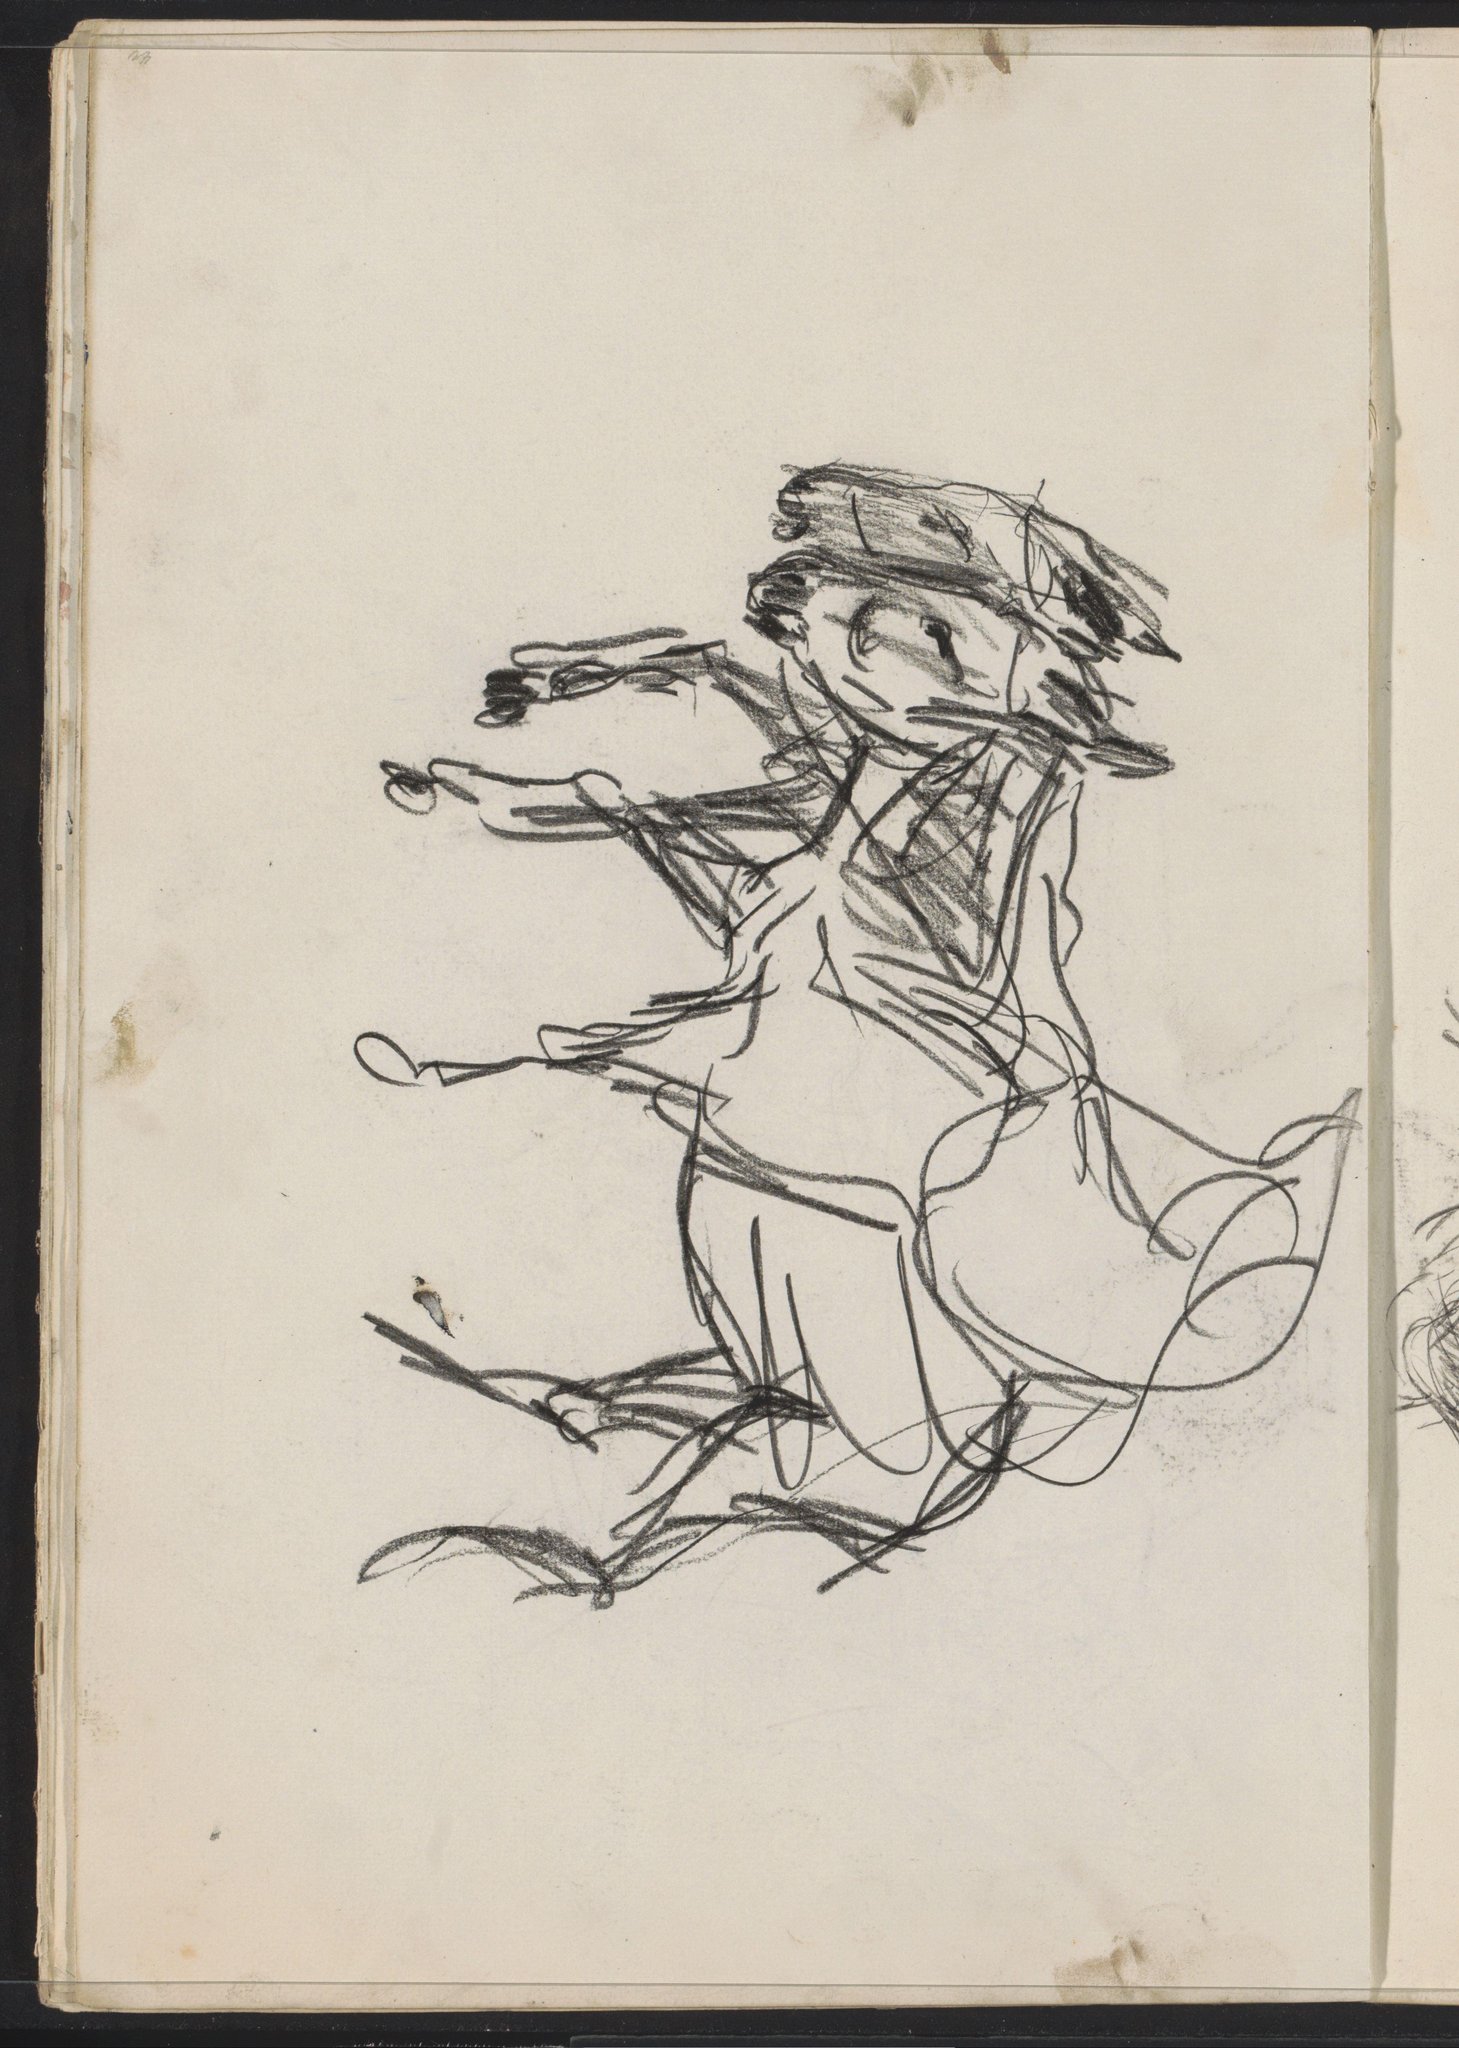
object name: sketchbook leaf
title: Vrouw op een ezel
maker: isaac israels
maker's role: draughtsman, painter, print maker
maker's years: 1865-1934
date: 1875-1934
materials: chalk, paper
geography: the hague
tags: adolescent, young woman, maiden, donkey-riding (on the beach)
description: Naast de ezel nog een tweede ezel. Blad 11 verso uit schetsboek LXIX met 25 bladen.